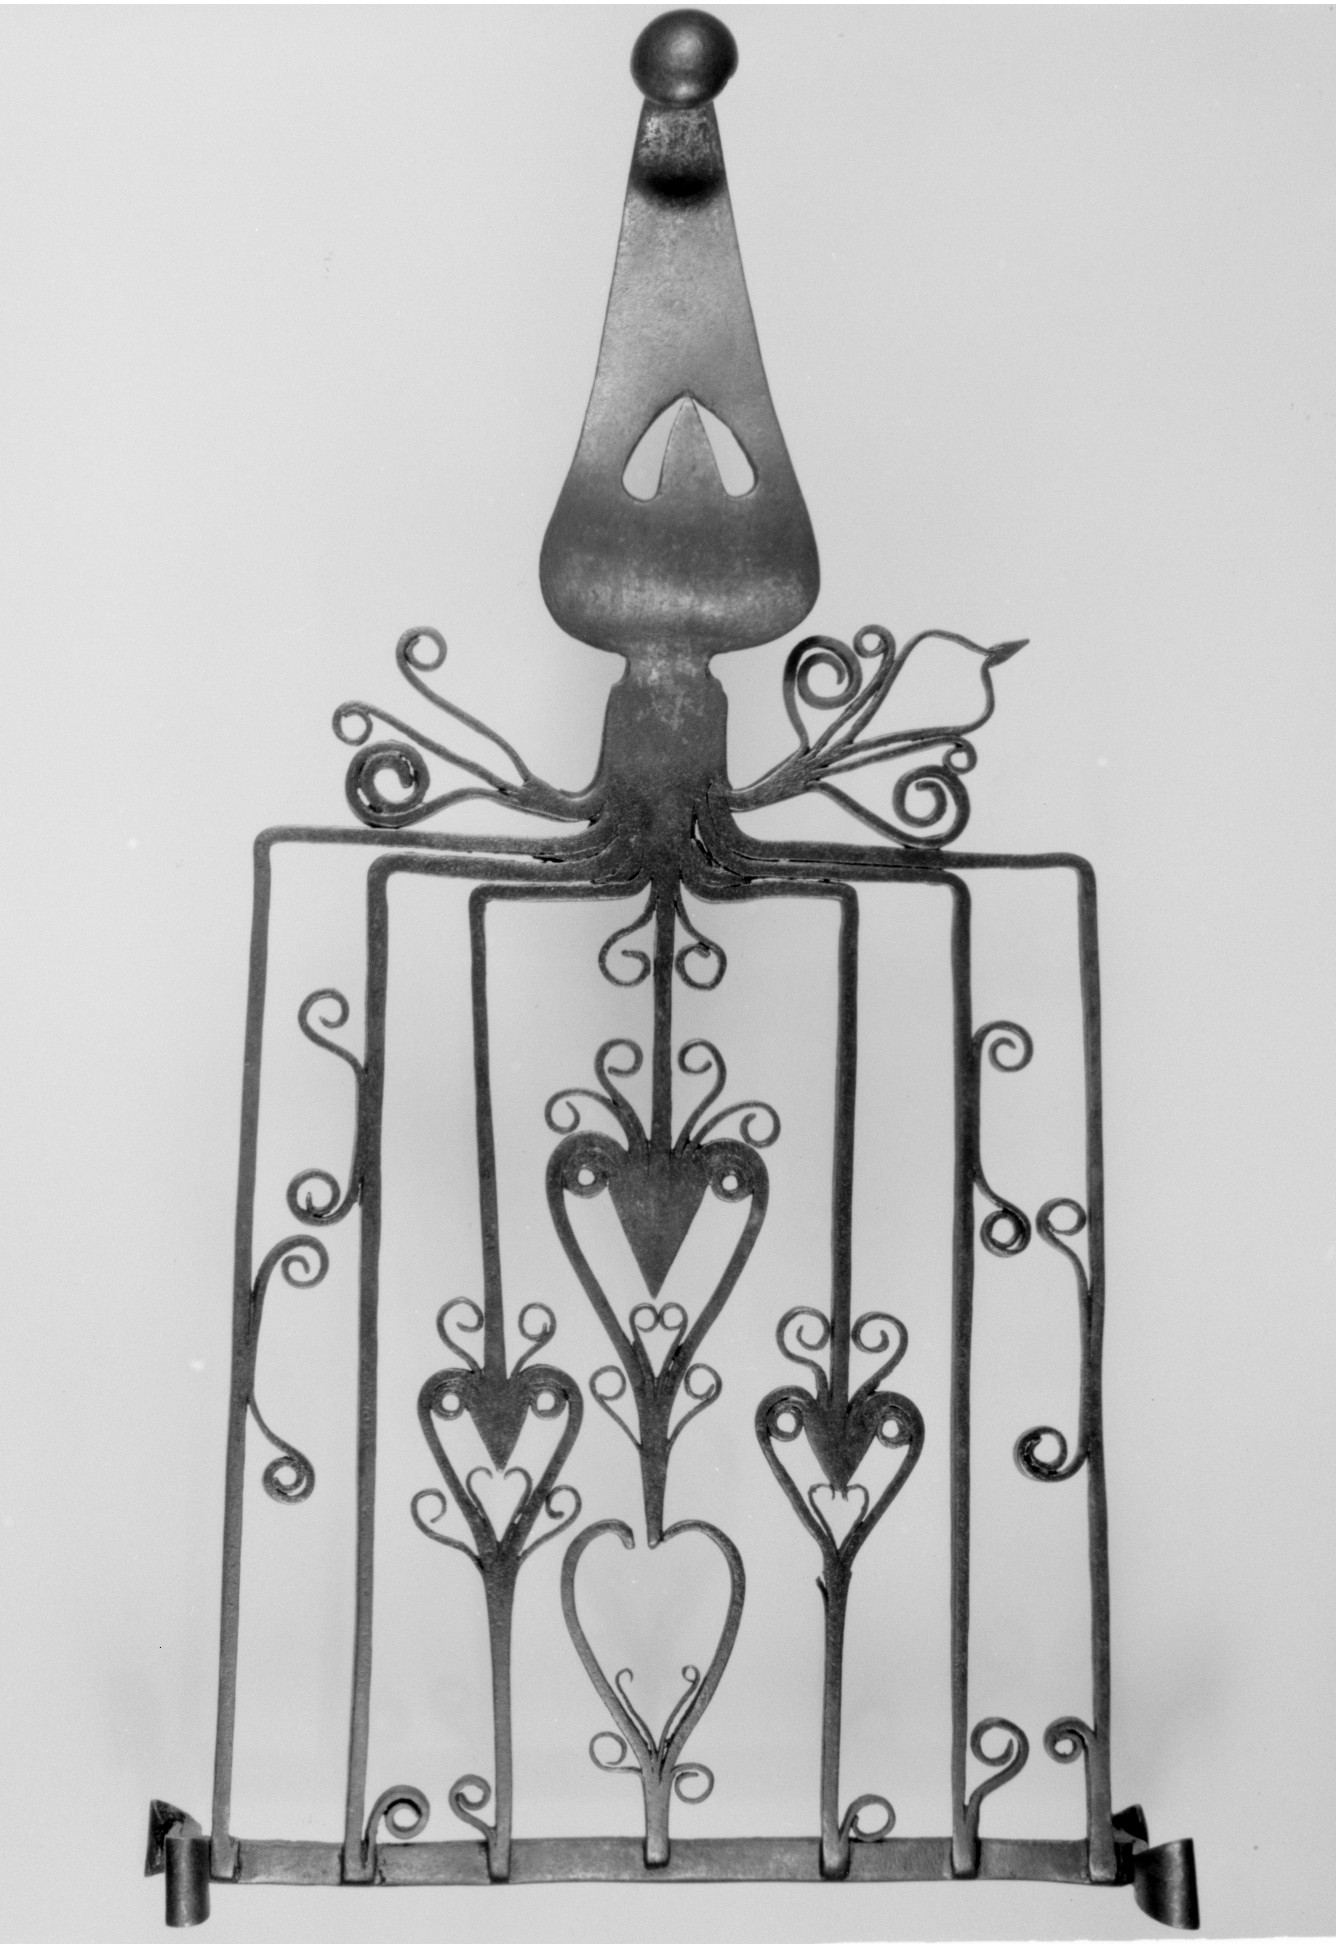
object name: trivet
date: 1701-1800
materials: iron